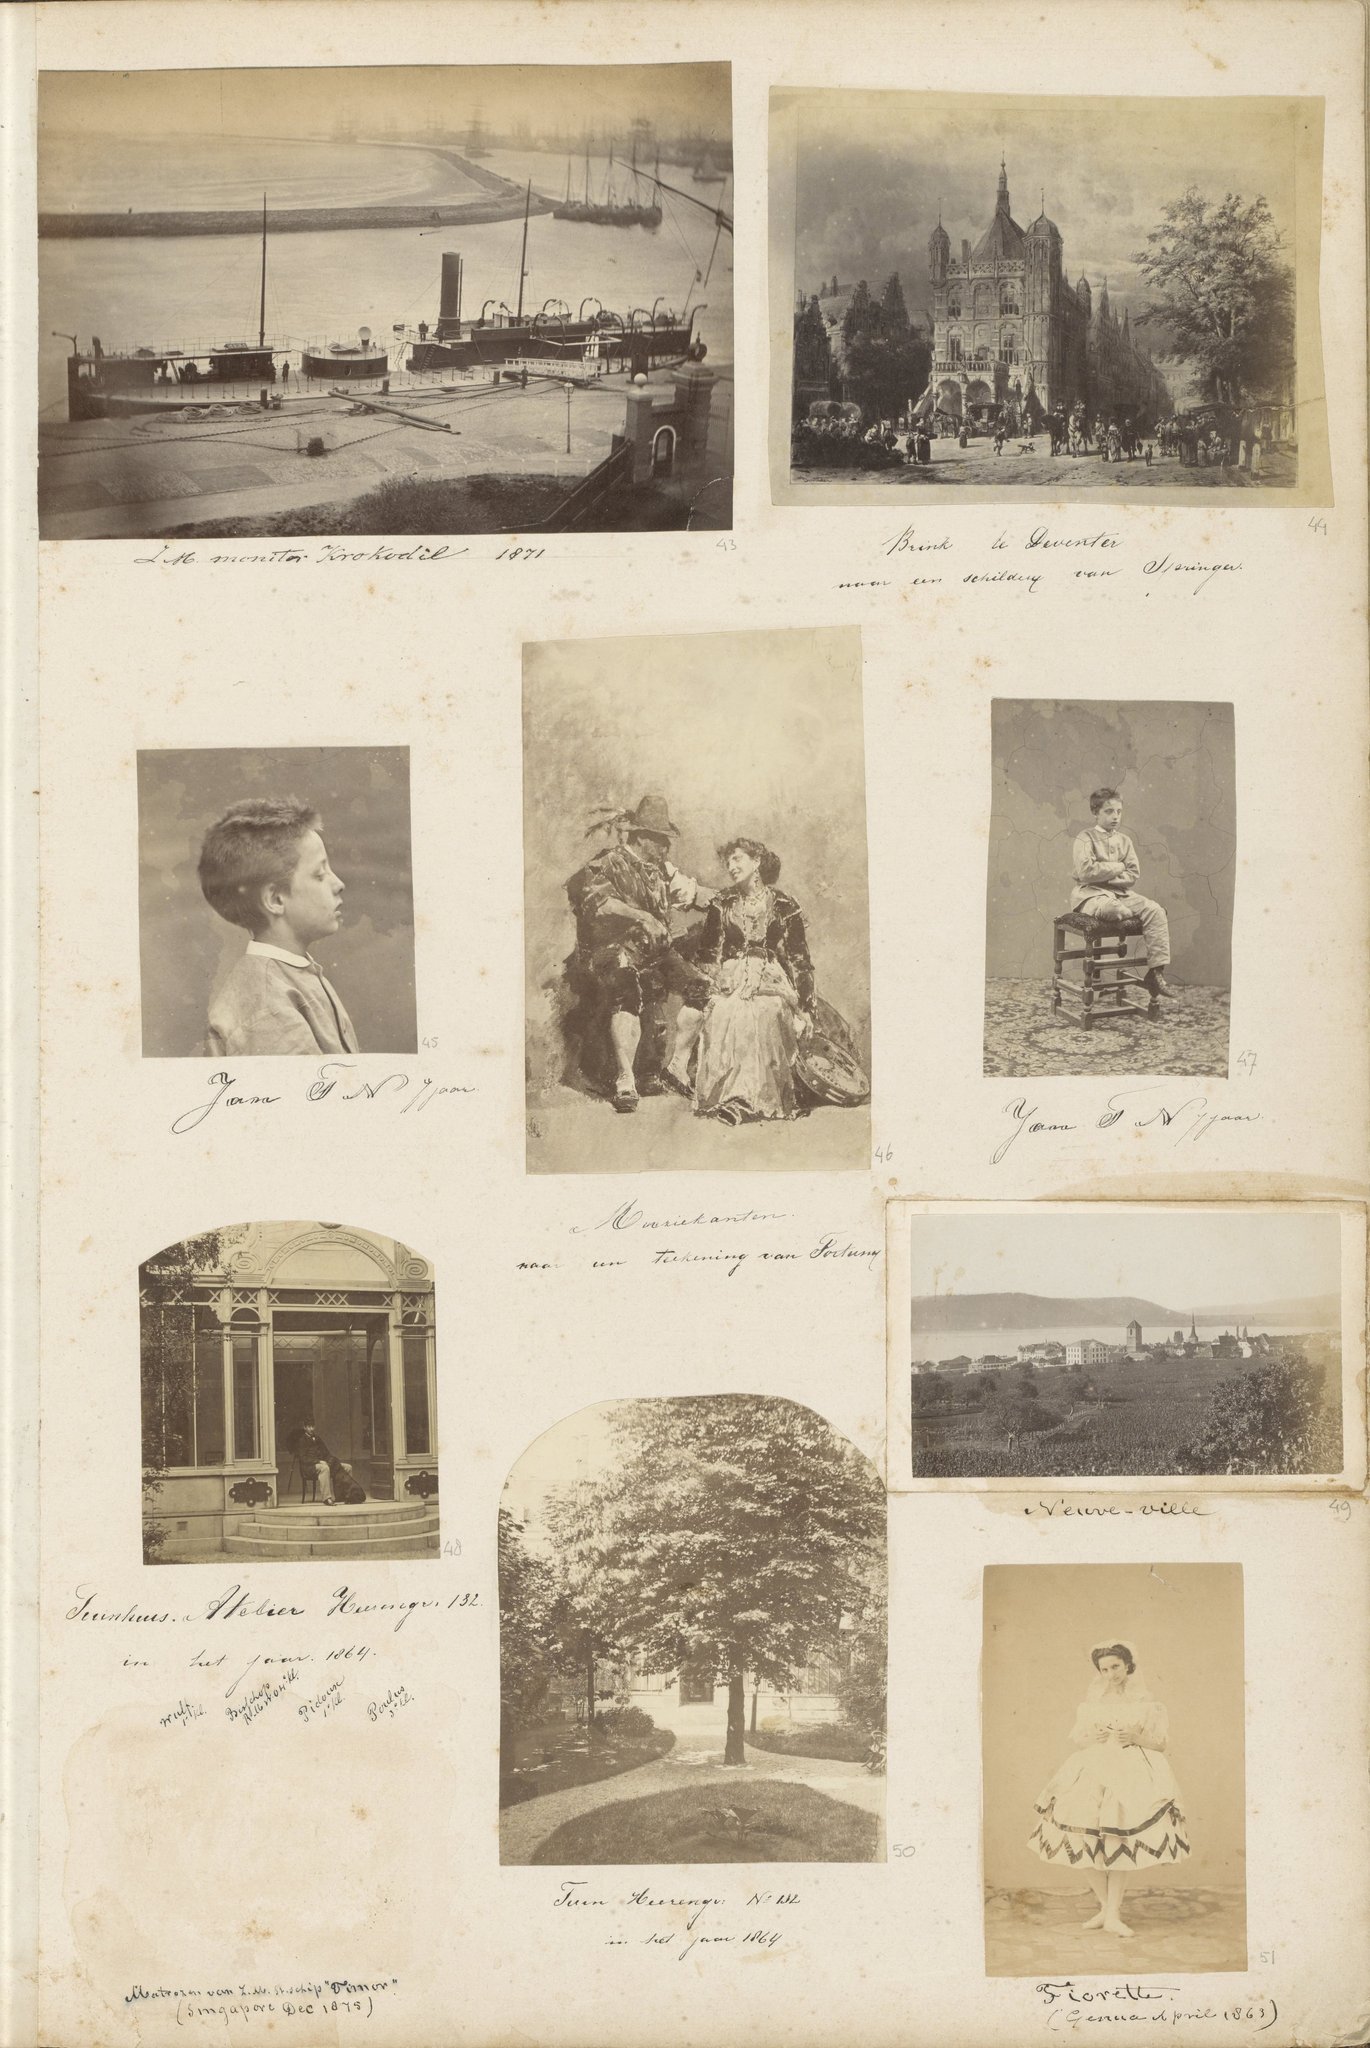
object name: album leaf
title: Z.M. monitor 'Krokodil' aan de kade van een haven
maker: Anonymous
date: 1871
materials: paper, photographic support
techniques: albumen print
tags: sailing-ship, sailing-boat (with name), pier, quay, wharf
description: Onderdeel van Fotoalbum van Robert Daniel Crommelin (1841-1907).